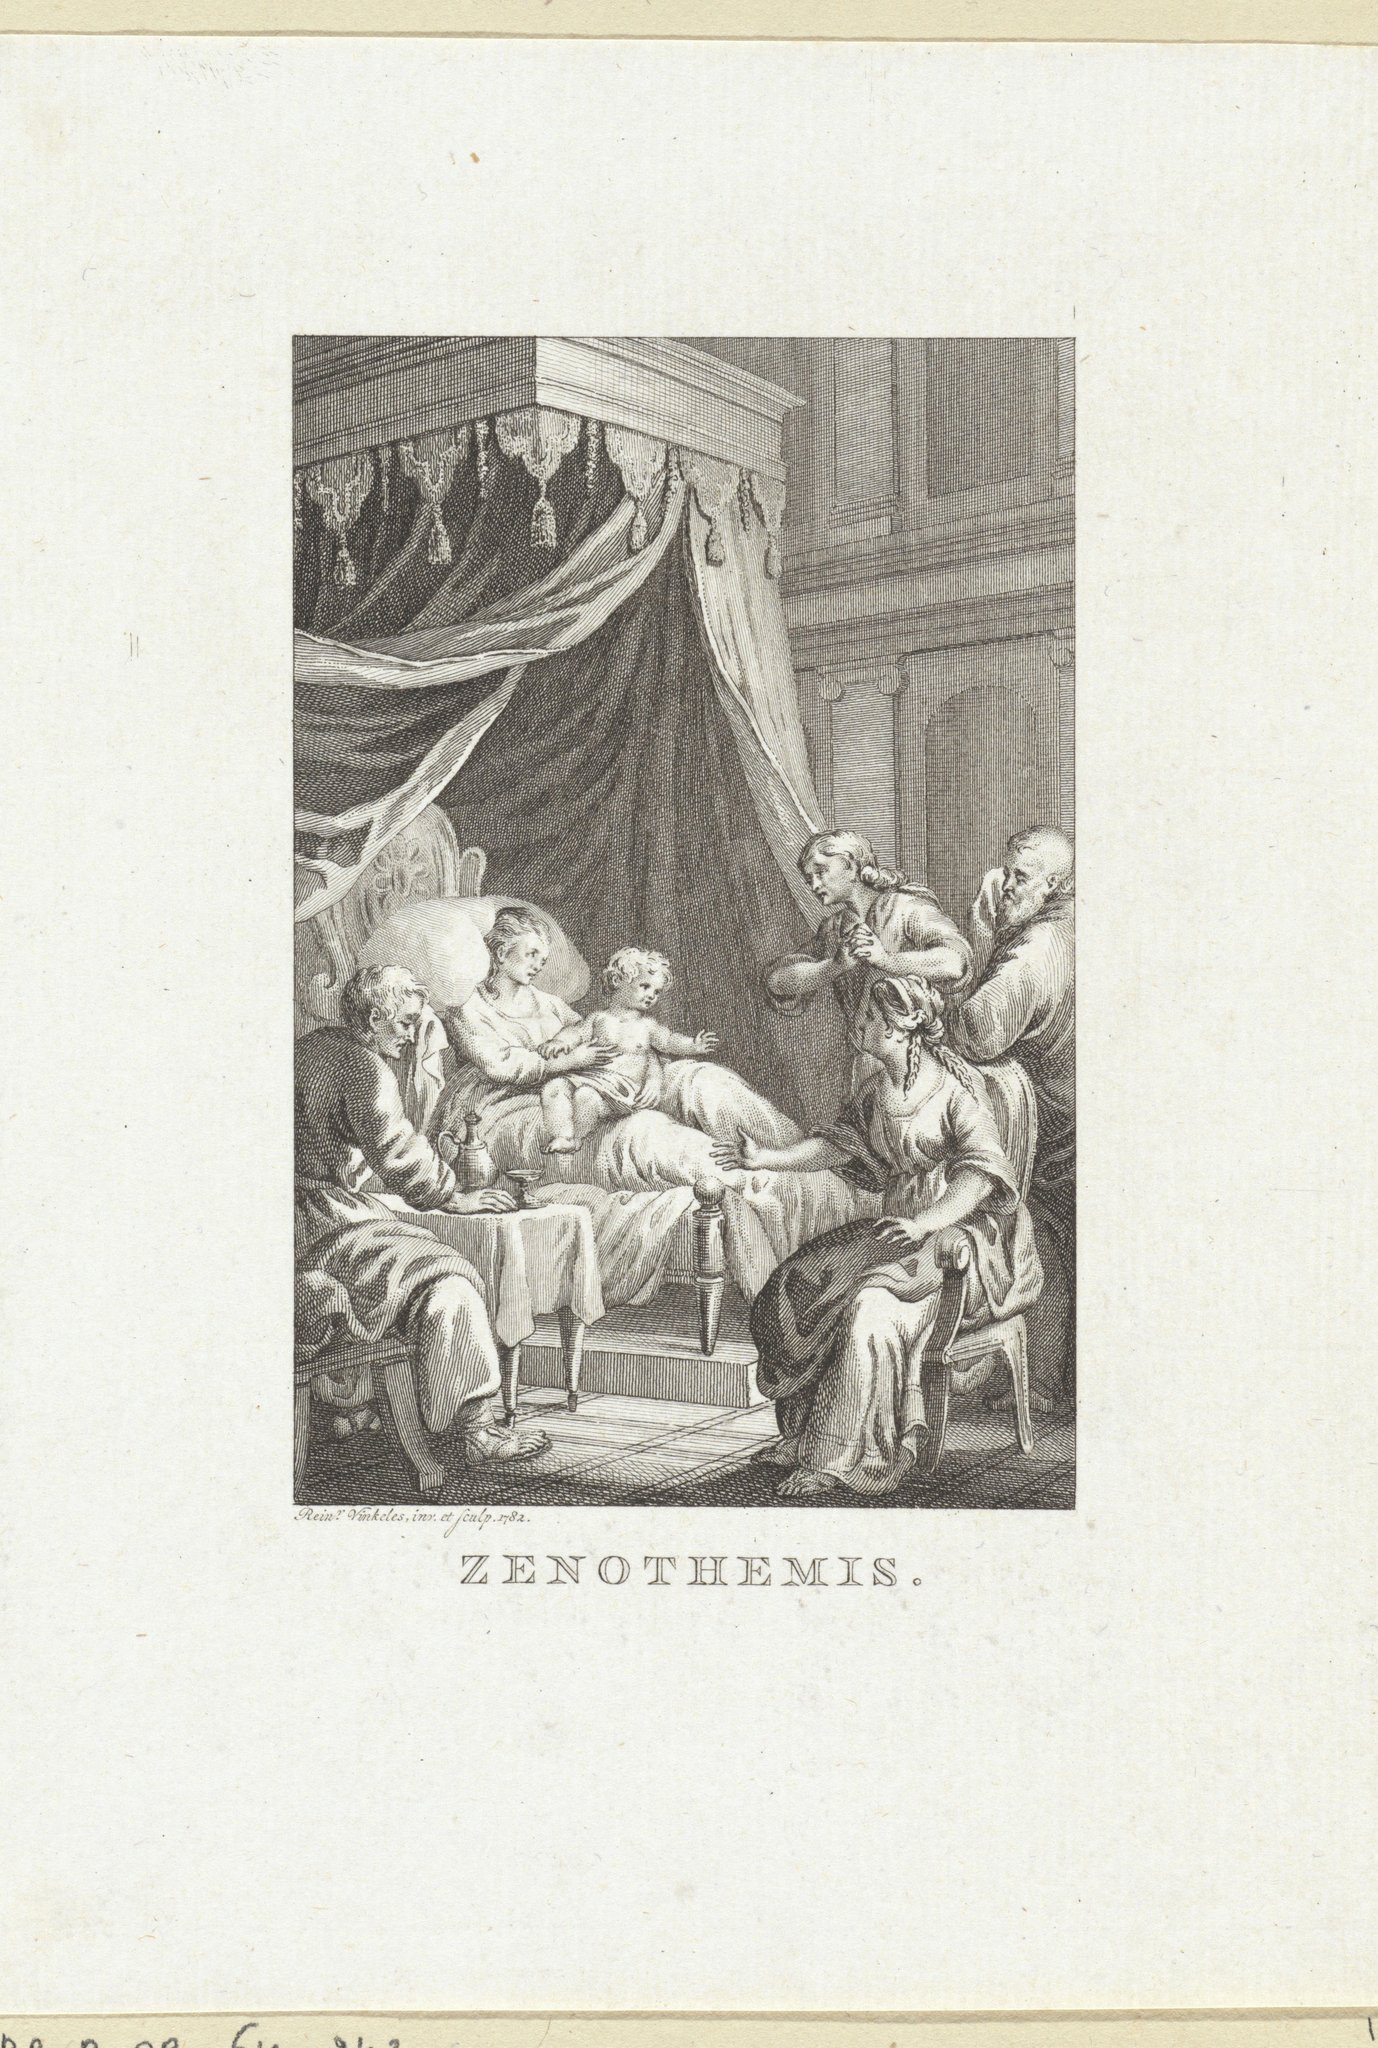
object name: print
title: Vrouw met een jong kind in een hemelbed omringd door bezoekers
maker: reinier vinkeles (i)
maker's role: draughtsman, print maker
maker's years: 1741-1816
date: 1782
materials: paper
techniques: engraving, etching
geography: amsterdam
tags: visiting; receiving guests; elegant company, infant, baby, four poster bed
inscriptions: collector's mark: Lugt 240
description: Deze prent is ook gebruikt als illustratie bij het verhaal 'Zenothemis' voor: Baculard d'Arnaud, F.T.M. de. Zedelijke verhaalen, deel 7. Amsterdam: A. Mens Jansz., 1782.